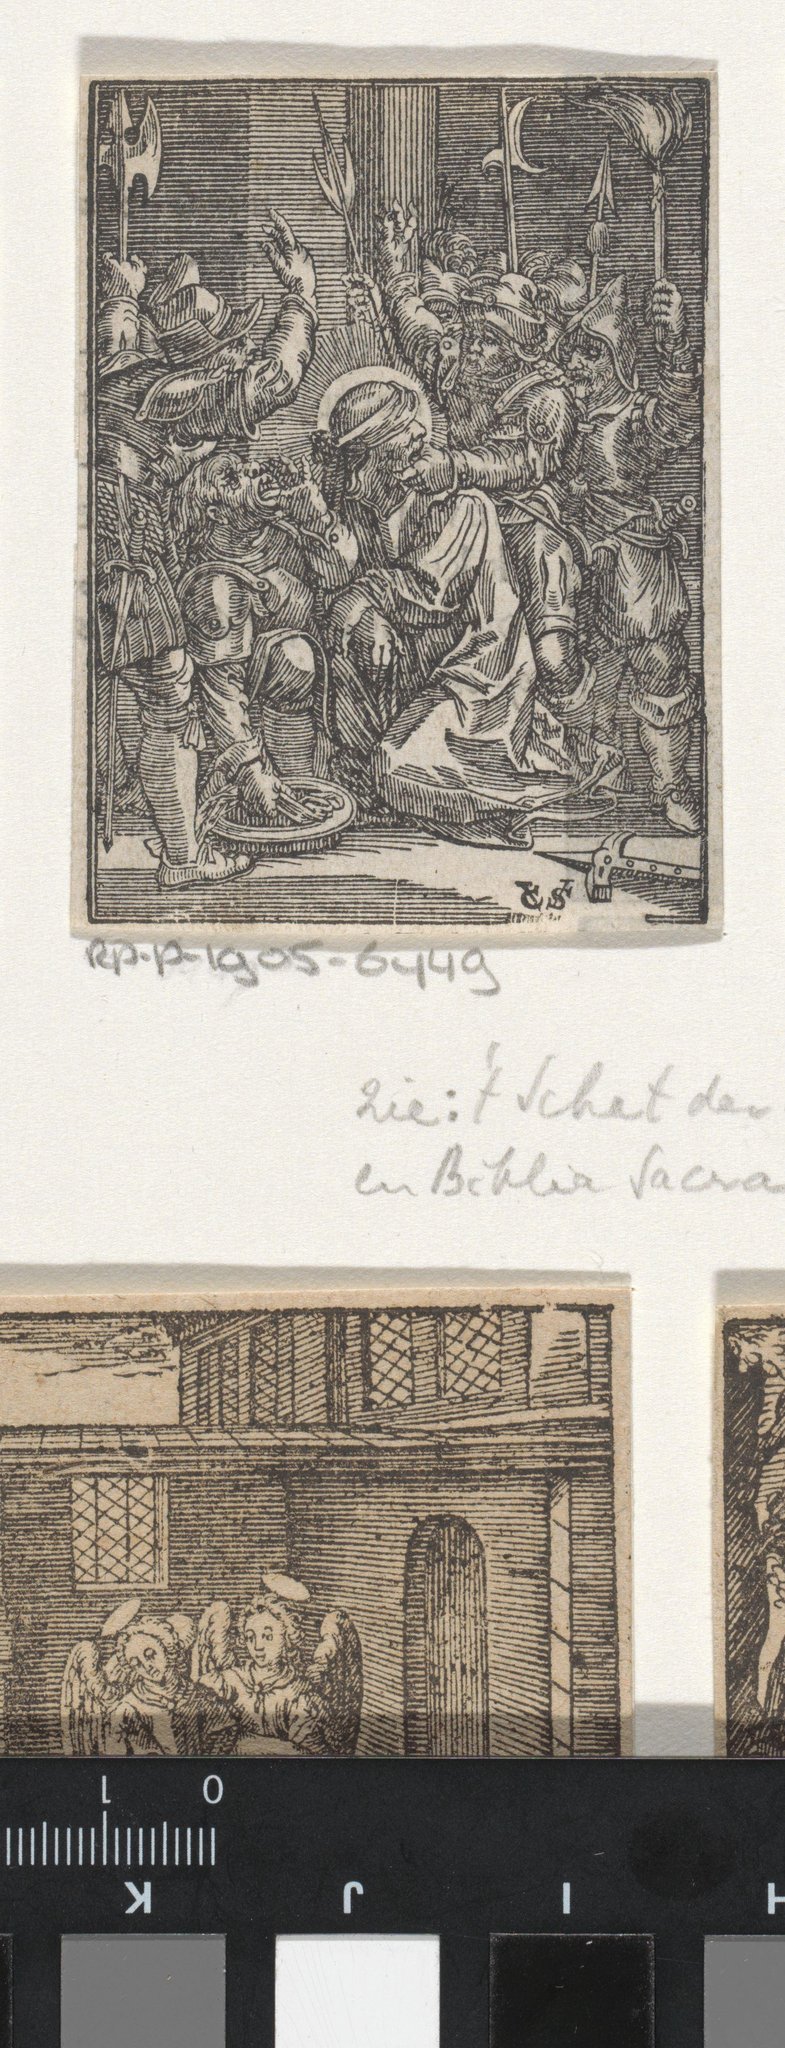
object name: book illustration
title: Bespotting van Christus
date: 1648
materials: paper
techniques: letterpress printing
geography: amsterdam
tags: mockings of christ, who may be blindfolded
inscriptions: collector's mark: Lugt 2228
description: Prent uit: Sichem, Christoffel van (II). 'tSchat der zielen, dat is: Het geheele leven ons Heeren Iesu Christi. Amsterdam: Pieter Jacobsz. Paets, 1648. Prent uit: Biblia sacra dat is De geheele Heylighe Schrifture bedeylt in 't Out en Nieu Testament. Amsterdam: Pieter Jacobsz. Paets, 1657.